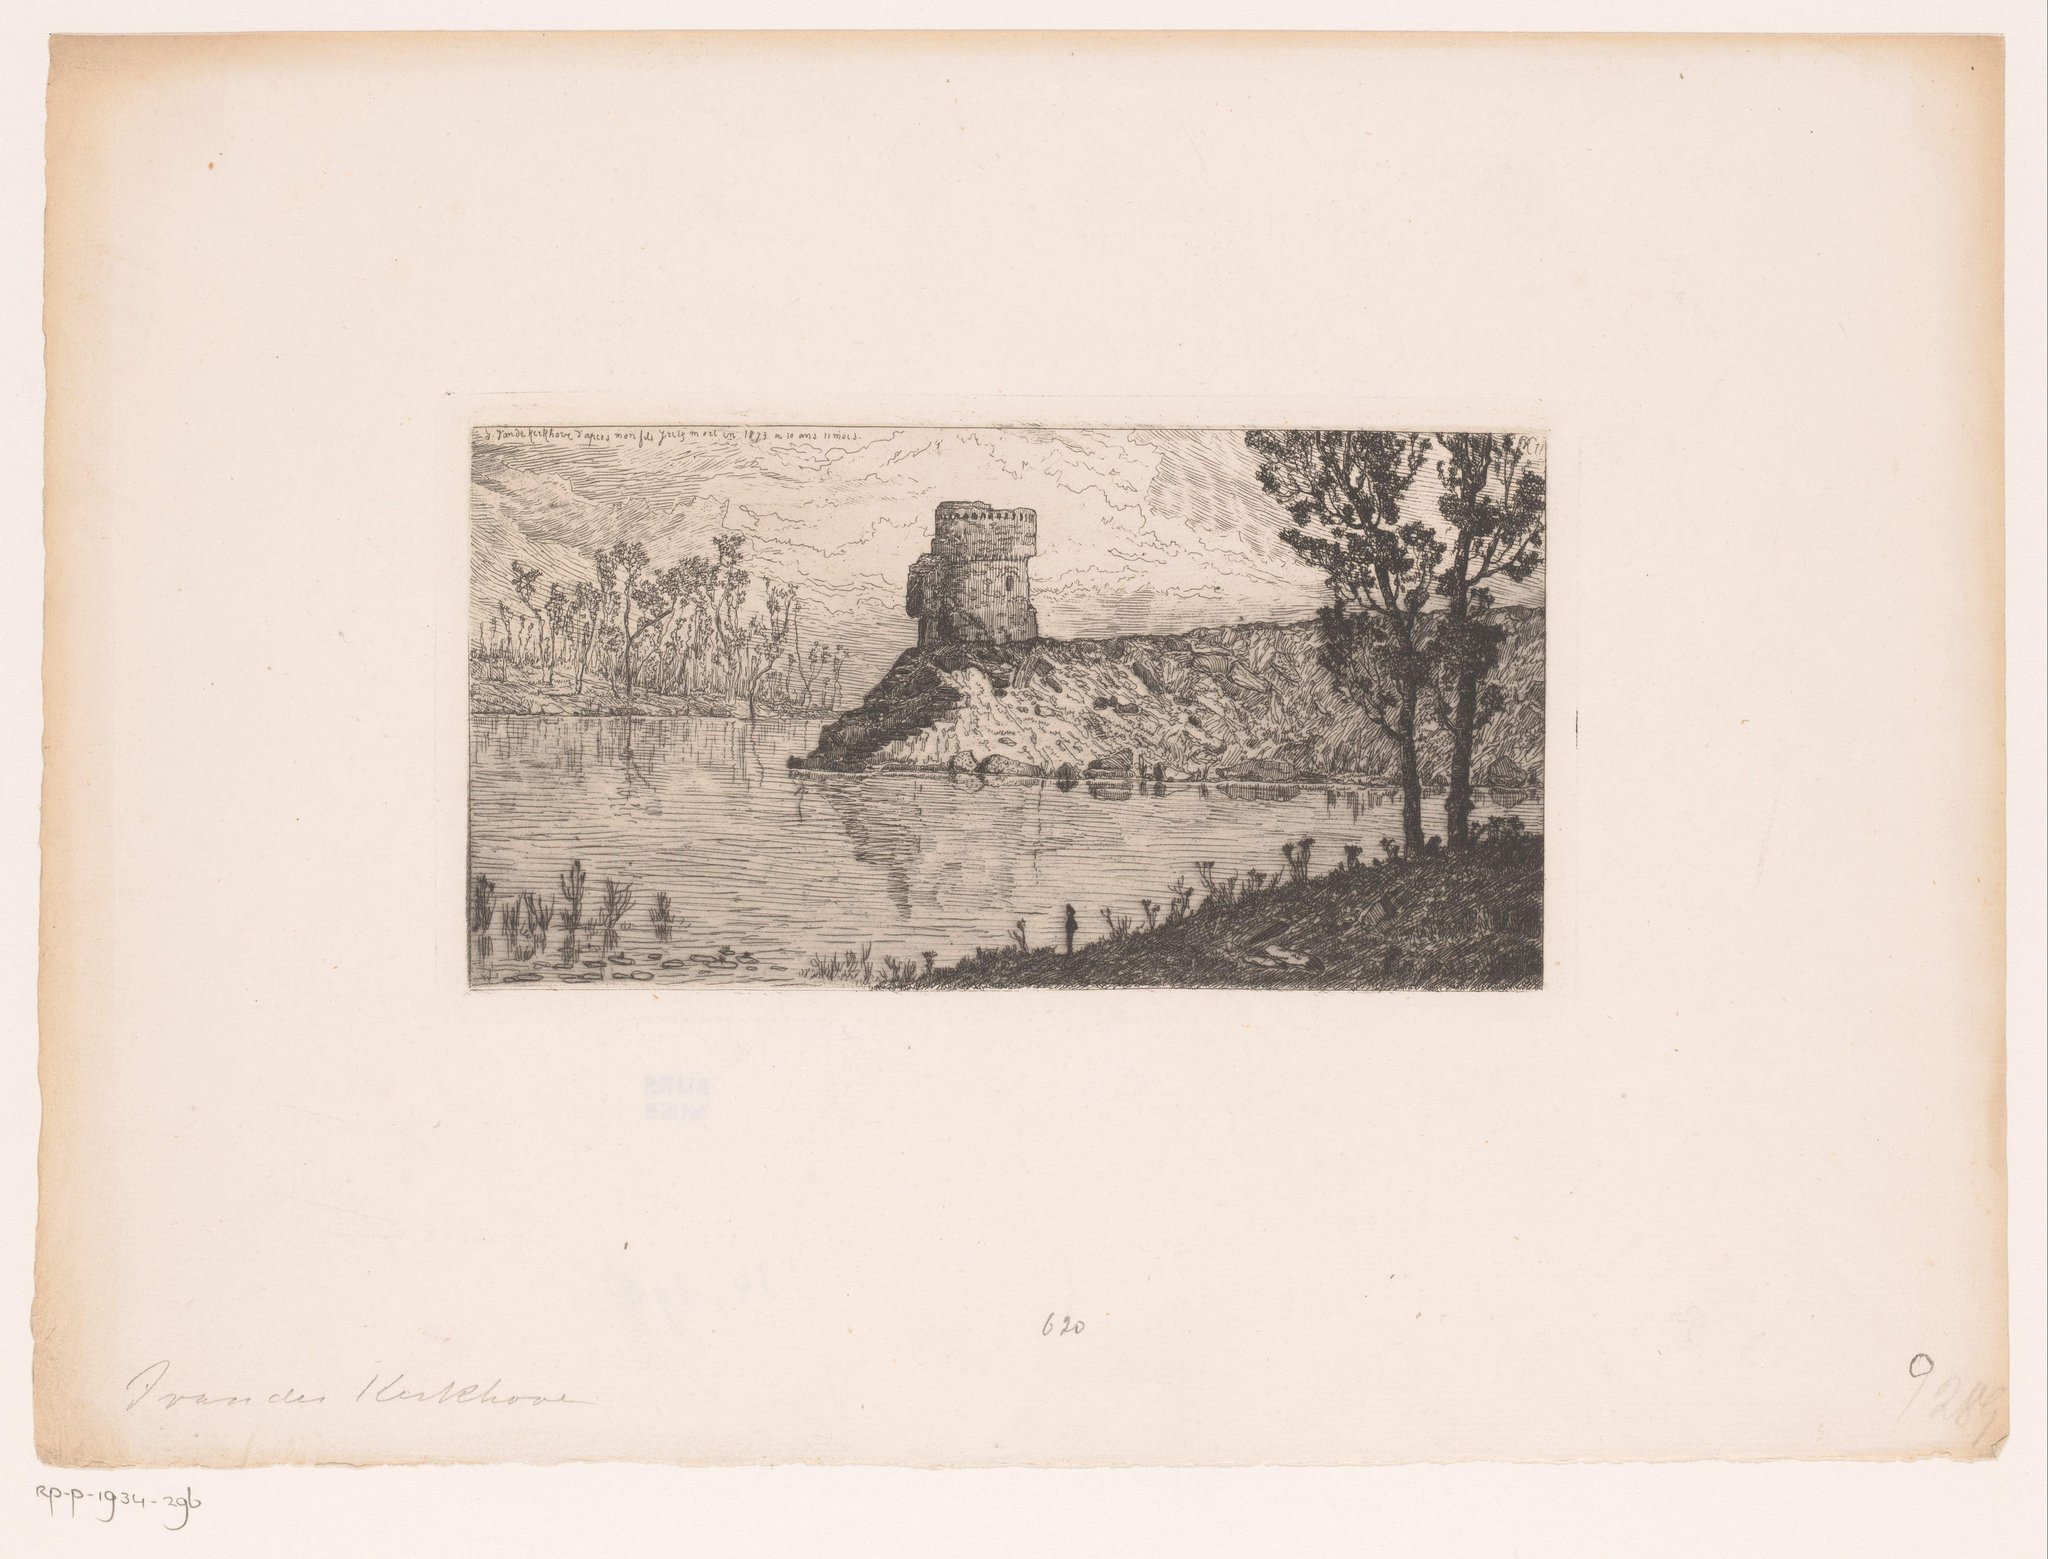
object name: print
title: Riviergezicht met ruïne van een toren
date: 1873-1881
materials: paper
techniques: drypoint, etching, intaglio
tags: river, ruin of a dwelling, house, castle, etc.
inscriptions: collector's mark: Lugt 2166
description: De etsen naar de schilderijen van Frédéric Van de Kerkhove werden na zijn dood door zijn vader en zuster gemaakt en uitgegeven in twee reeksen. De eerste werd in 1877 uitgegeven door het Journal des Beaux-Arts et de la Littérature: Cahier de 25 Eaux-fortes d'après Frédéric van de Kerkhove, gravées par son père et sa sœur. De tweede reeks van 126 etsen werd, ook in 1877, in Parijs uitgegeven bij A. Lévy onder de titel Cent eaux-fortes gravées par J. Van de Kerkhove d'après les tableaux de Frédéric Van de Kerkhove, mort en 1873 à l'âge de 10 ans et 11 mois.